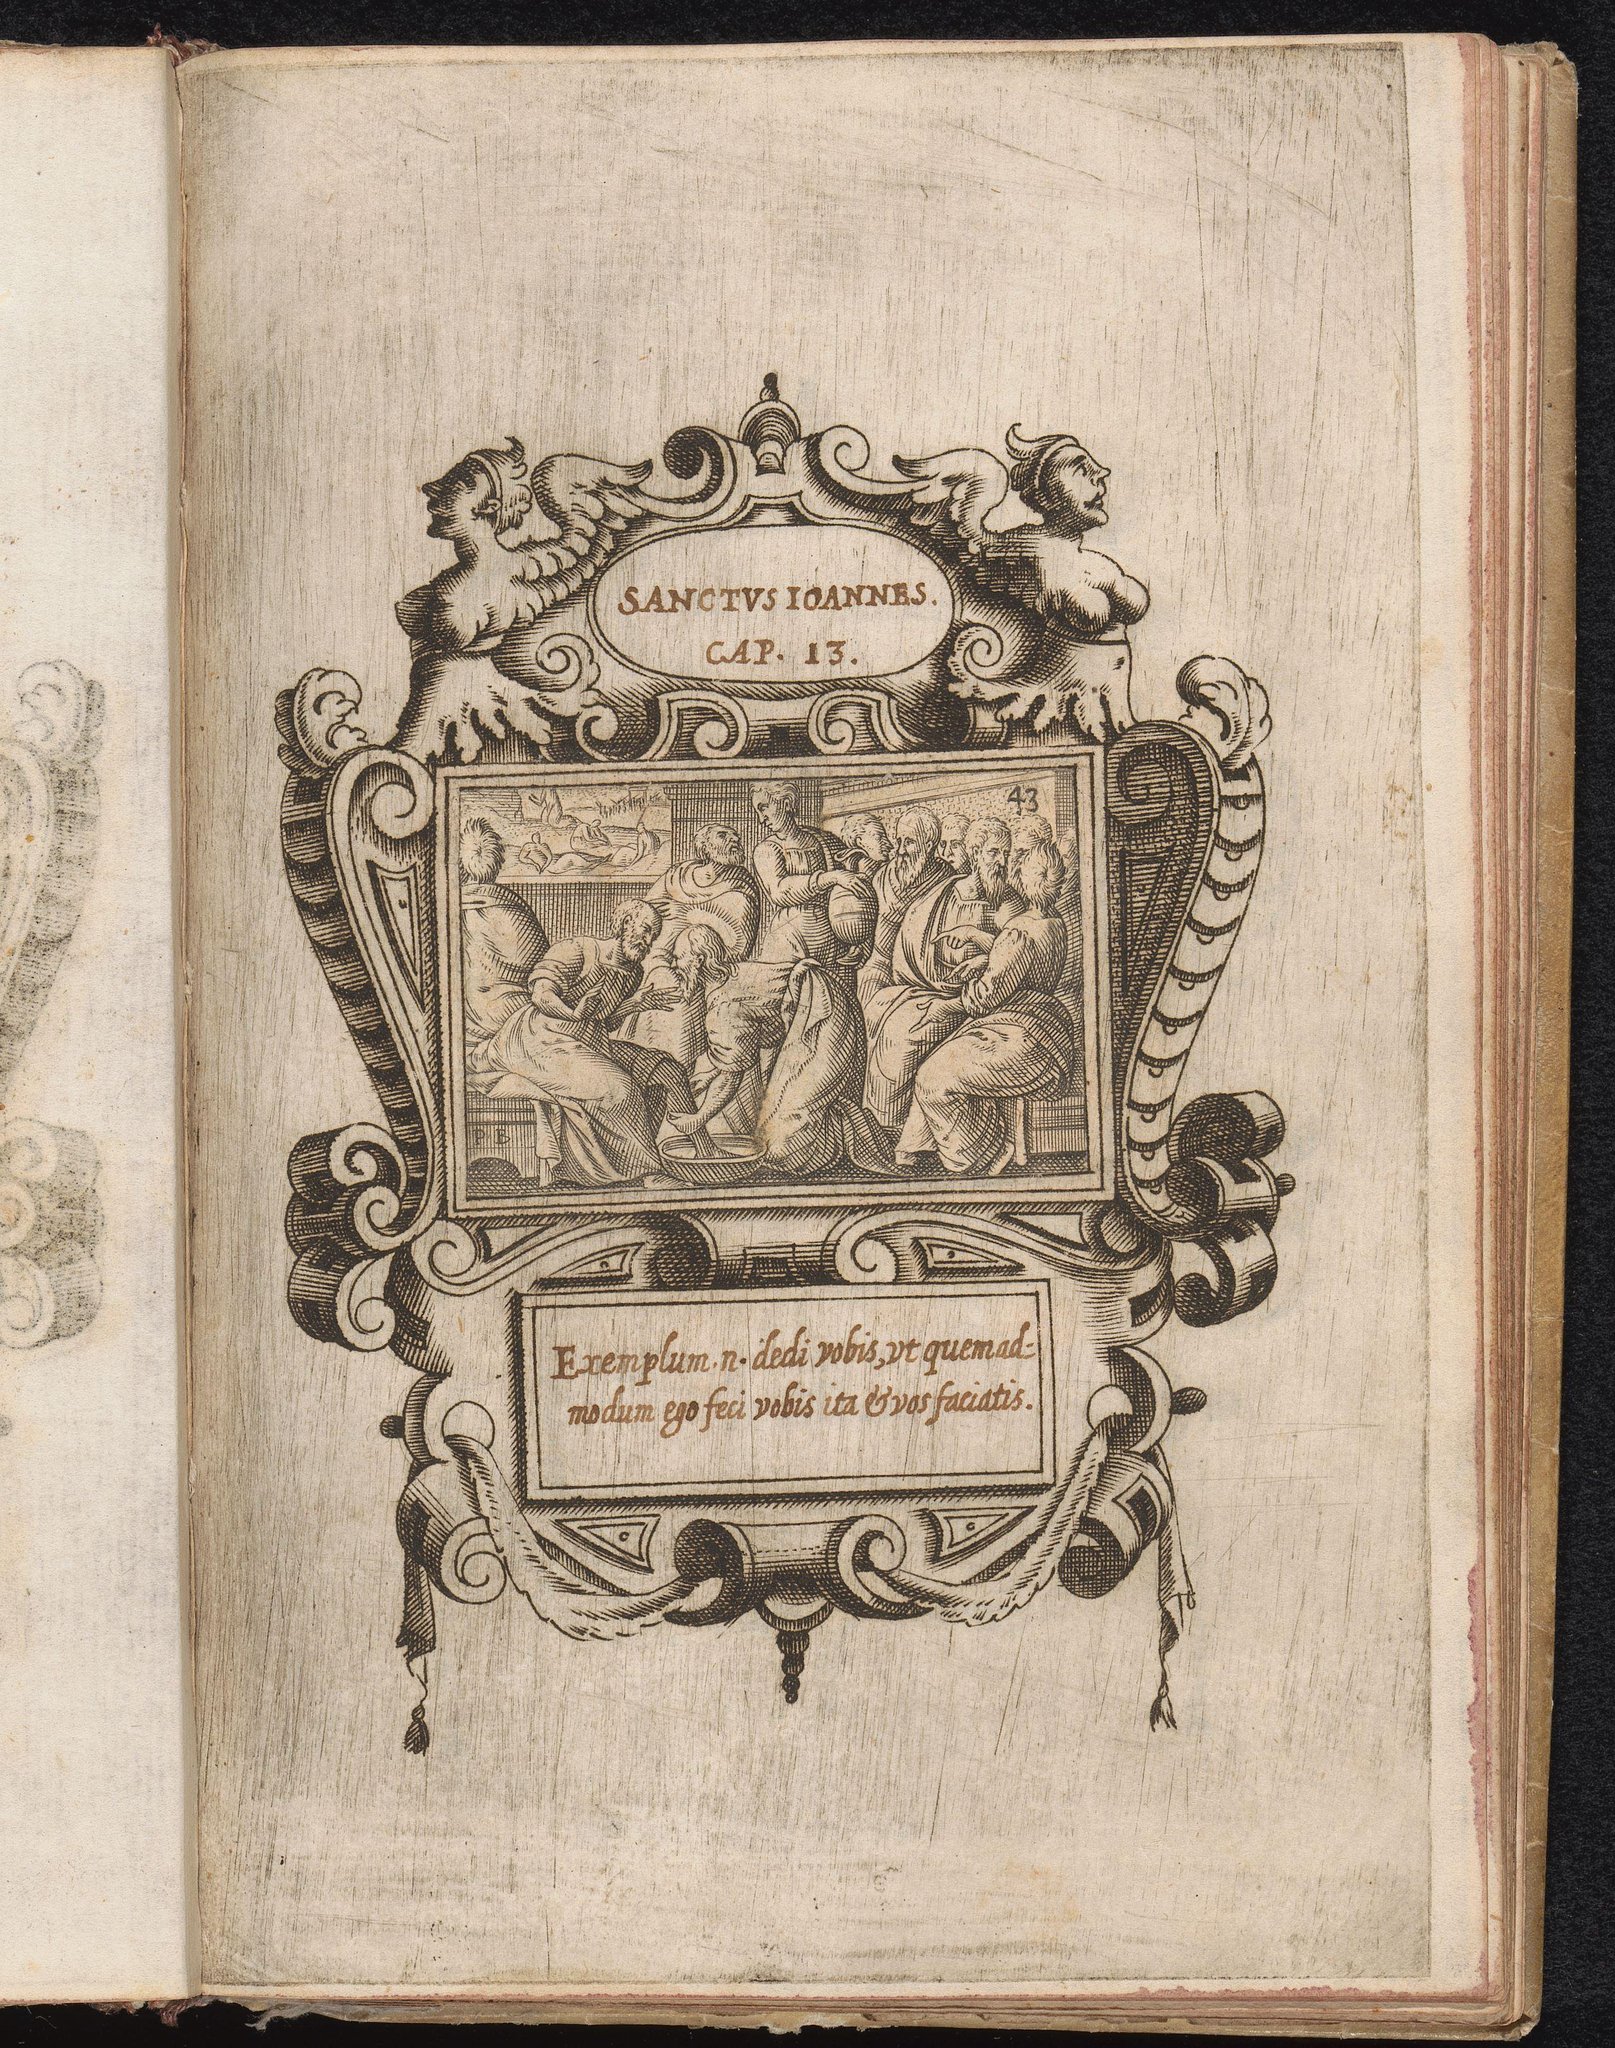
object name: print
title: Christus wast de voeten van Petrus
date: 1570-1610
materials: paper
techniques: engraving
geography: antwerp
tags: christ washes peter's feet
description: Christus wast de voeten van Petrus. Onderdeel van een prentalbum met titelprent en 56 scènes uit het Nieuwe Testament. Elke voorstelling gemonteerd in een gravure met ornamentele cartouches waarin een venster is gesneden en voorzien van handgeschreven bijbelpassages.